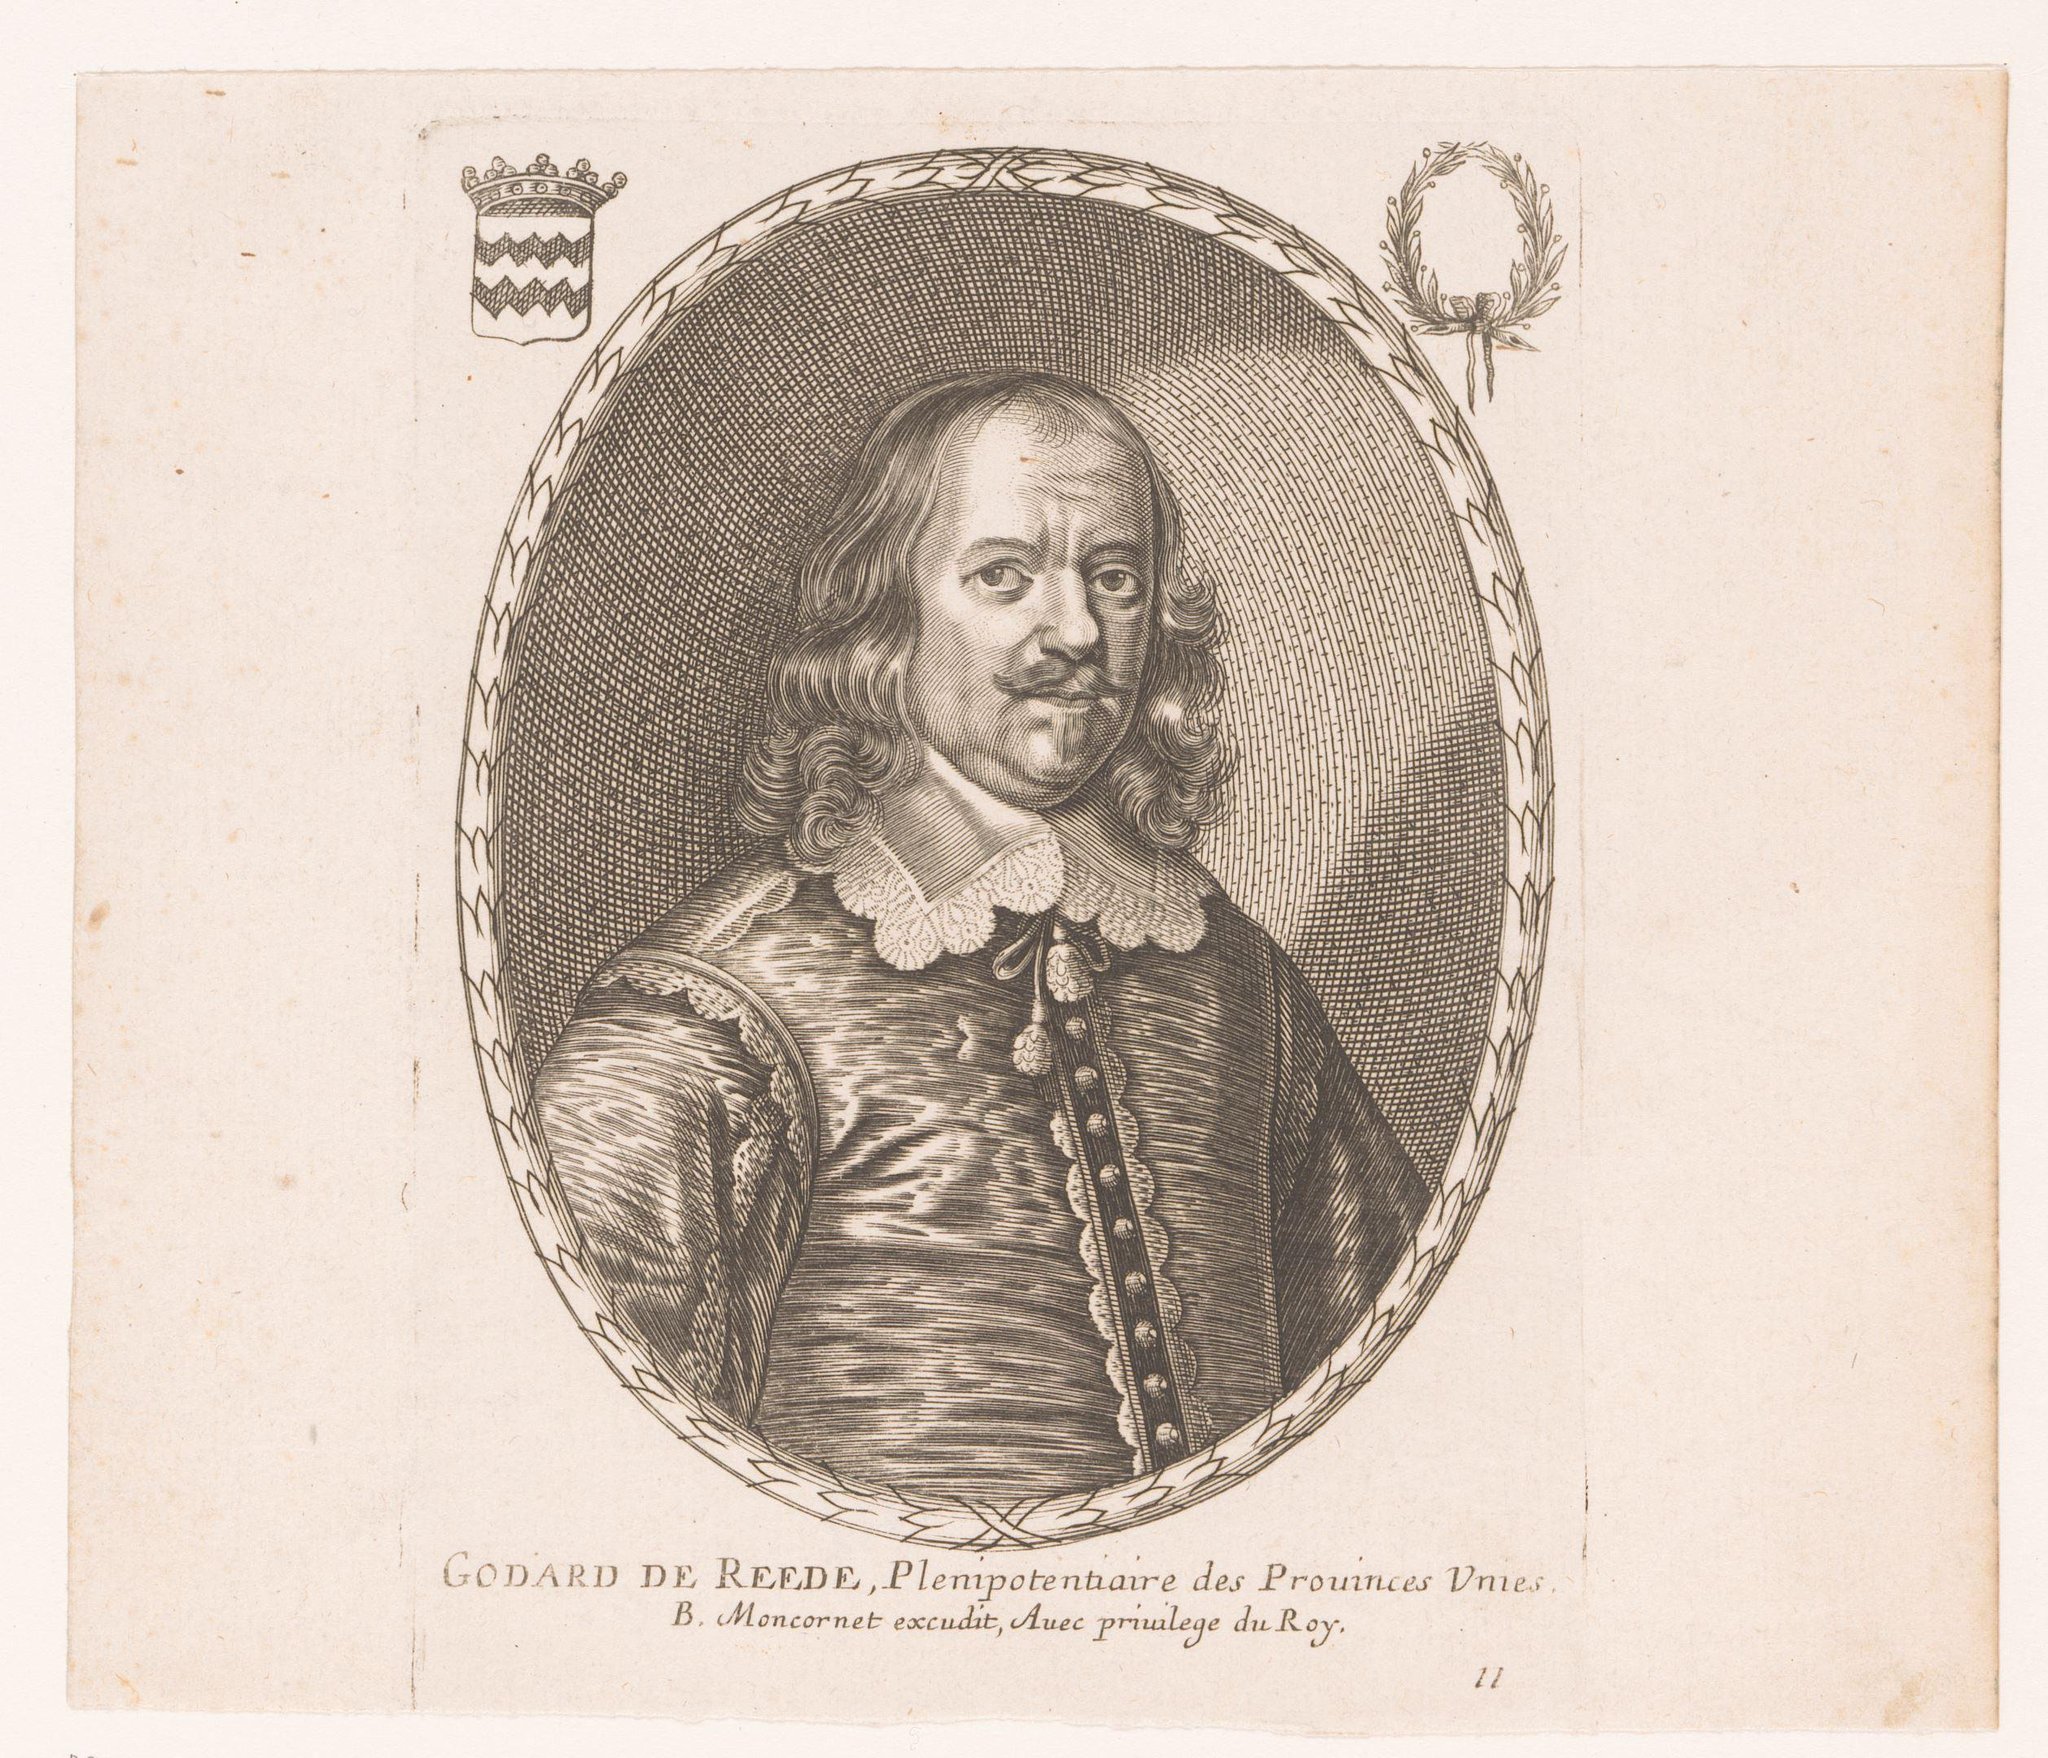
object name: print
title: Portret van Godard van Reede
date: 1651-1668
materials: paper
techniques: engraving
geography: france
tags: historical persons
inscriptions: collector's mark: Lugt 2228